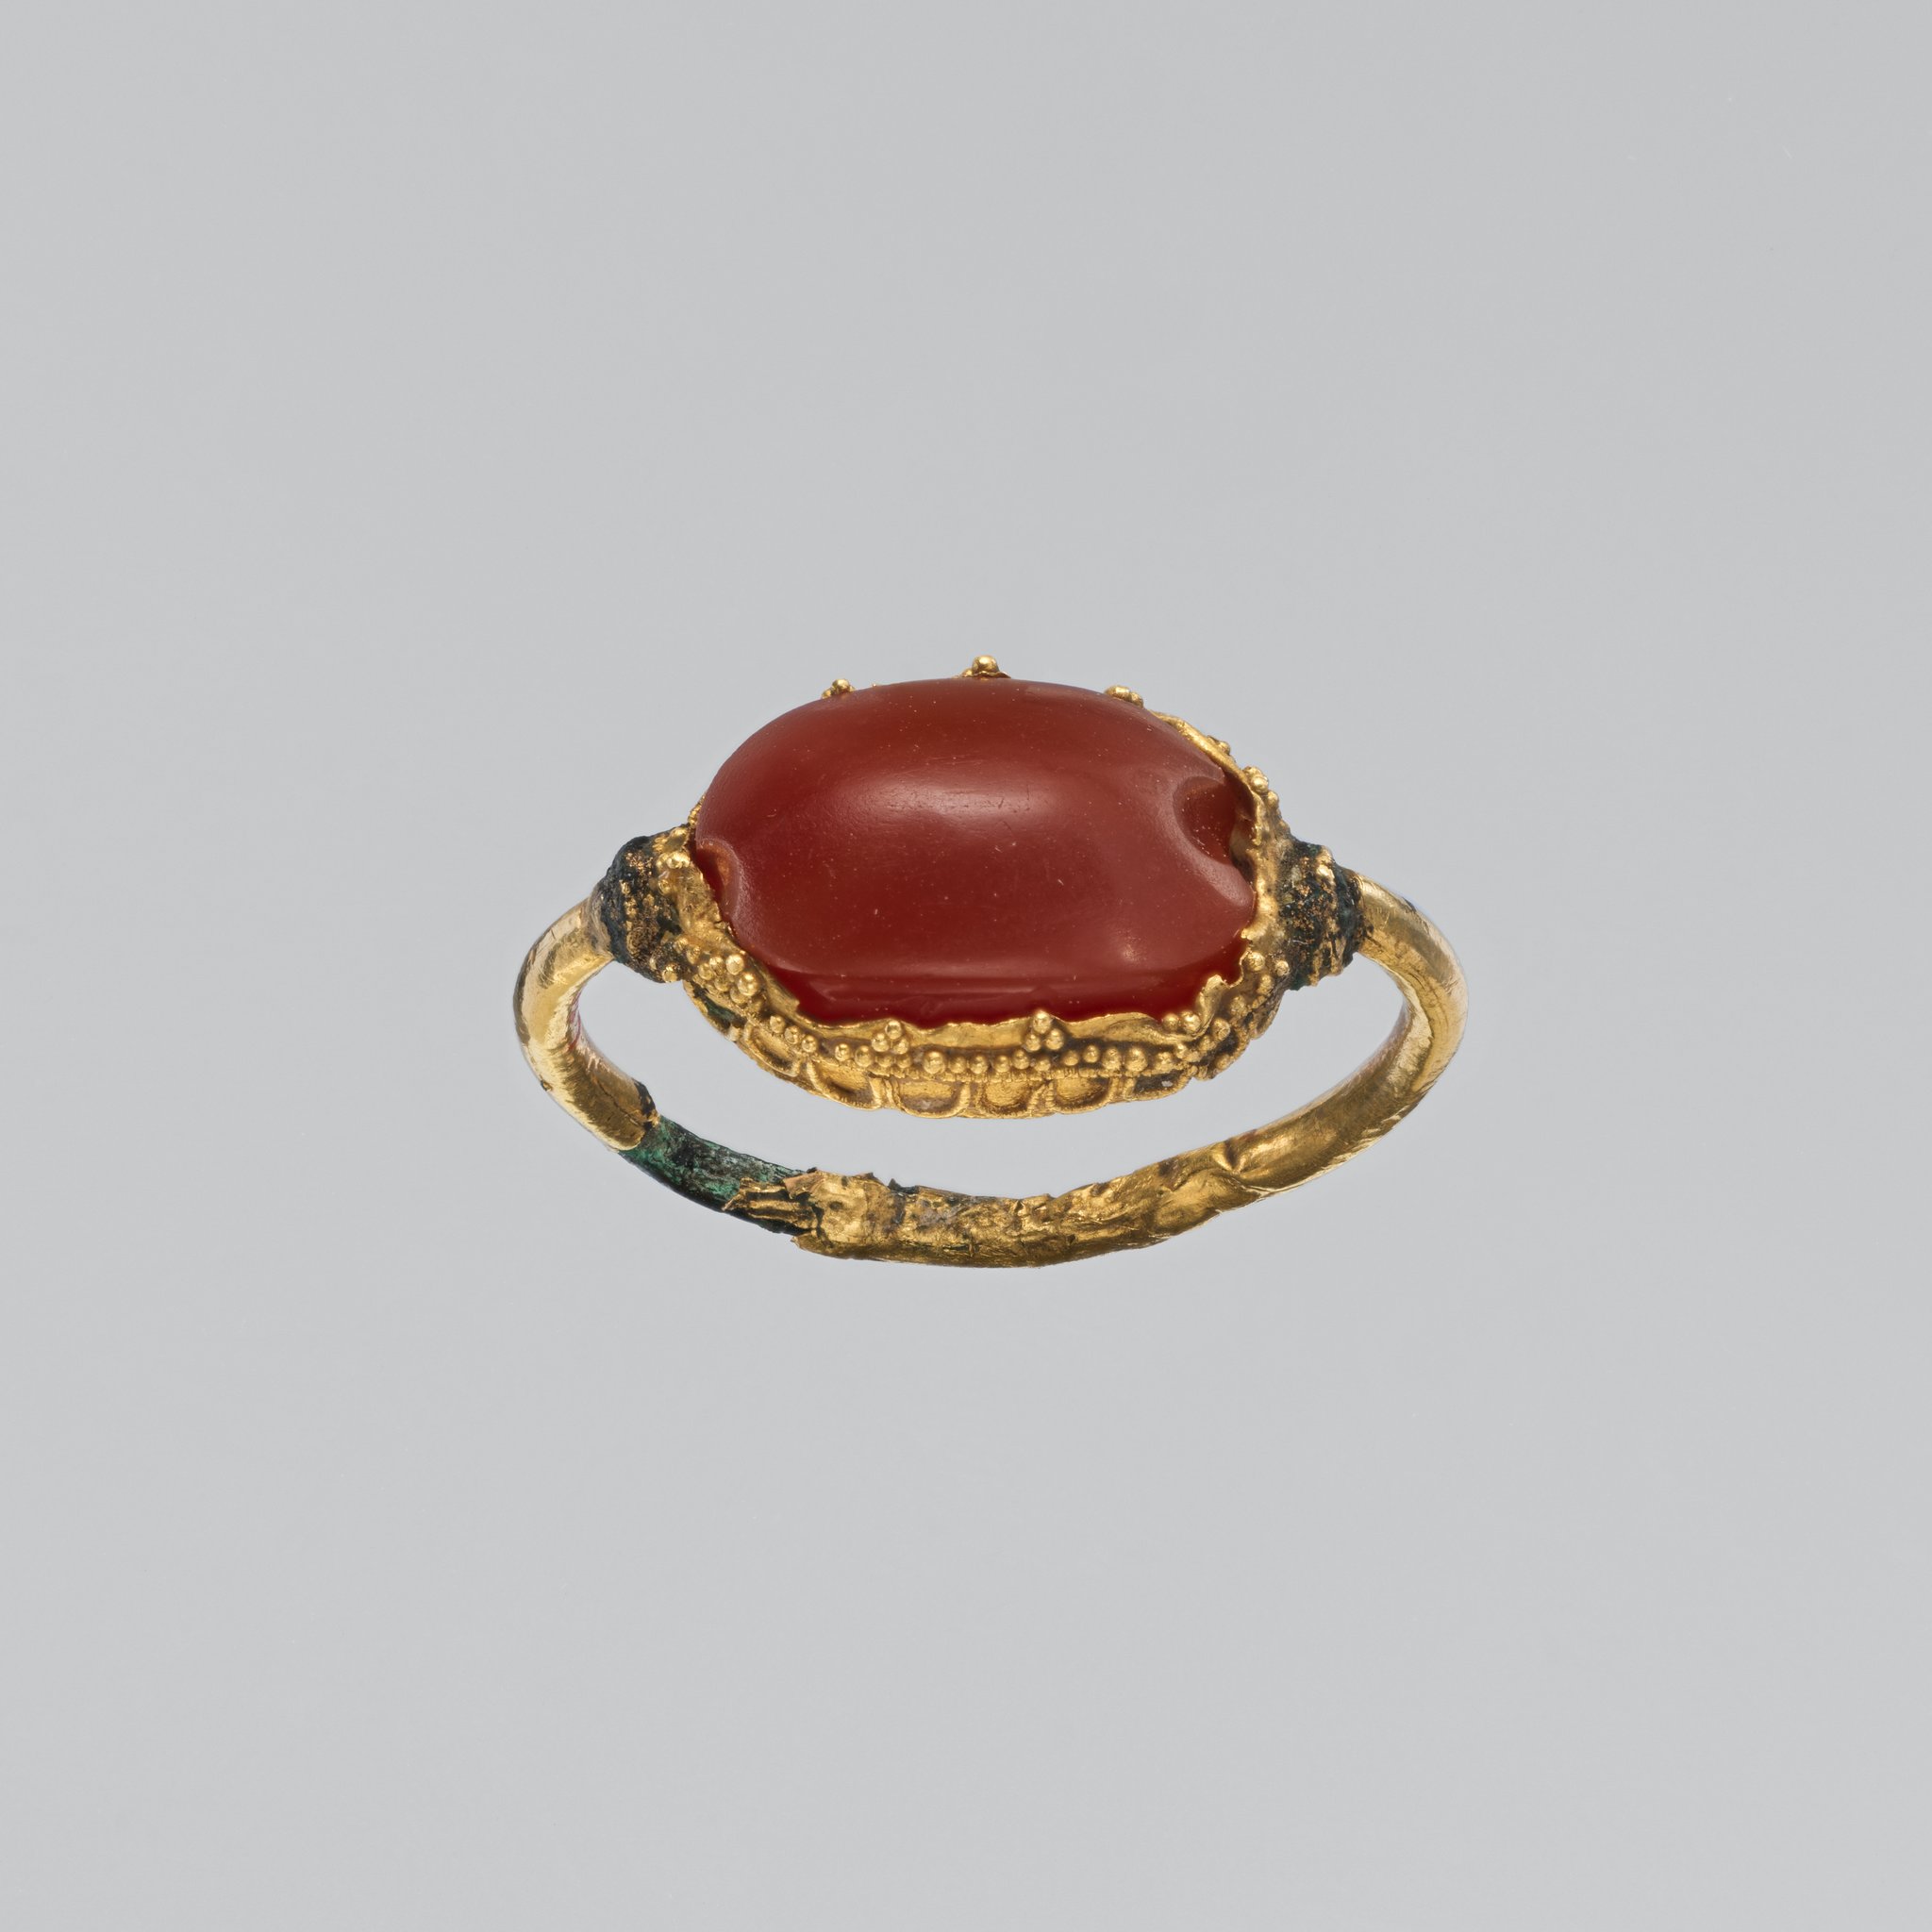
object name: ring with scaraboid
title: Gold and carnelian scaraboid ring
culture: greek, cypriot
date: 450 BCE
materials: gemstone, gold